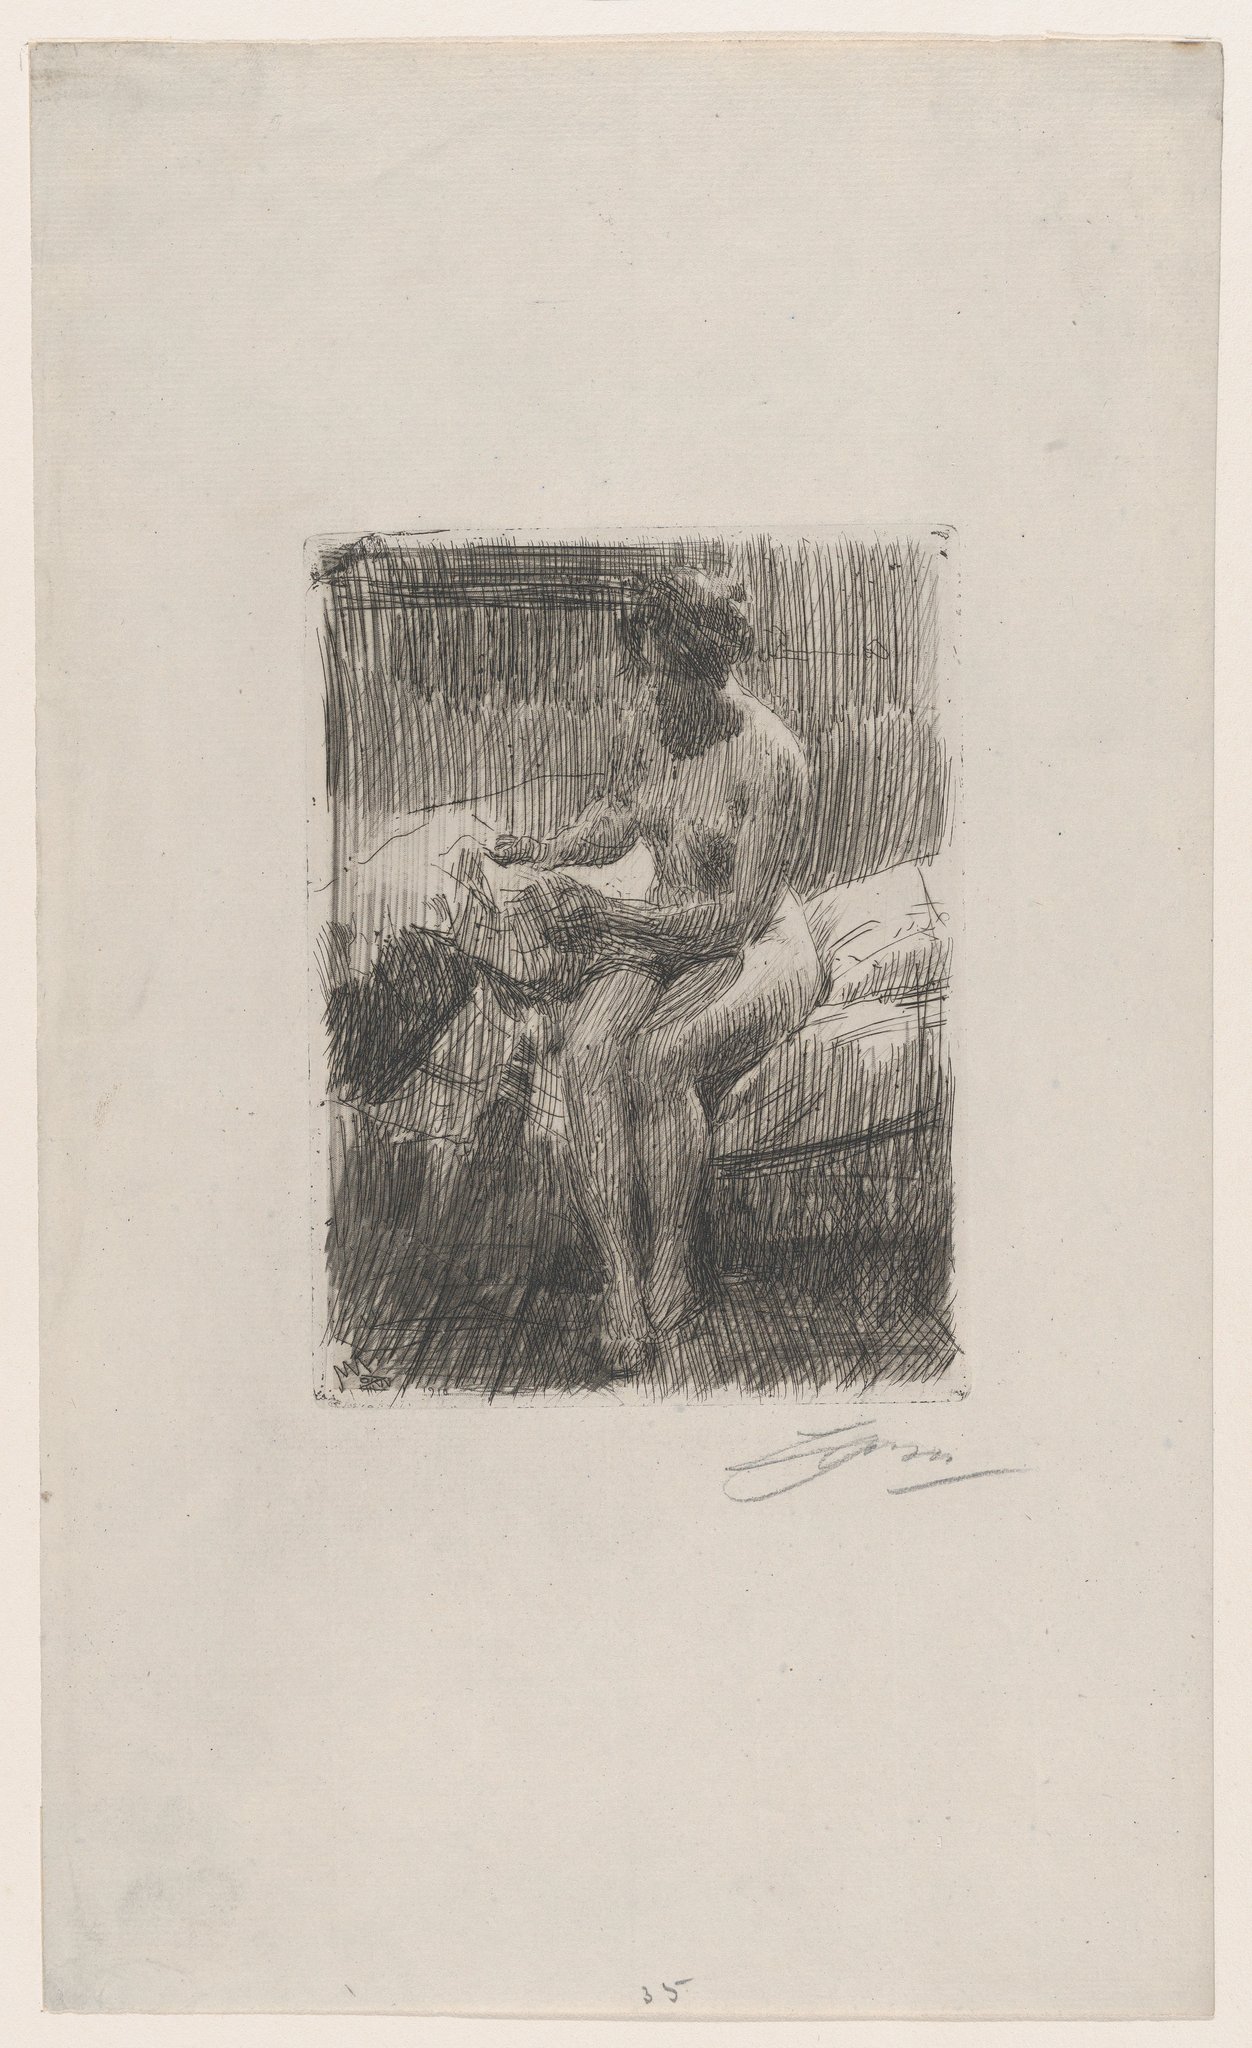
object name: print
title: Model Reading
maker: anders zorn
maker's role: artist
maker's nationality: swedish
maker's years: 1860-1920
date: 1910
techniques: etching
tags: female nudes,reading